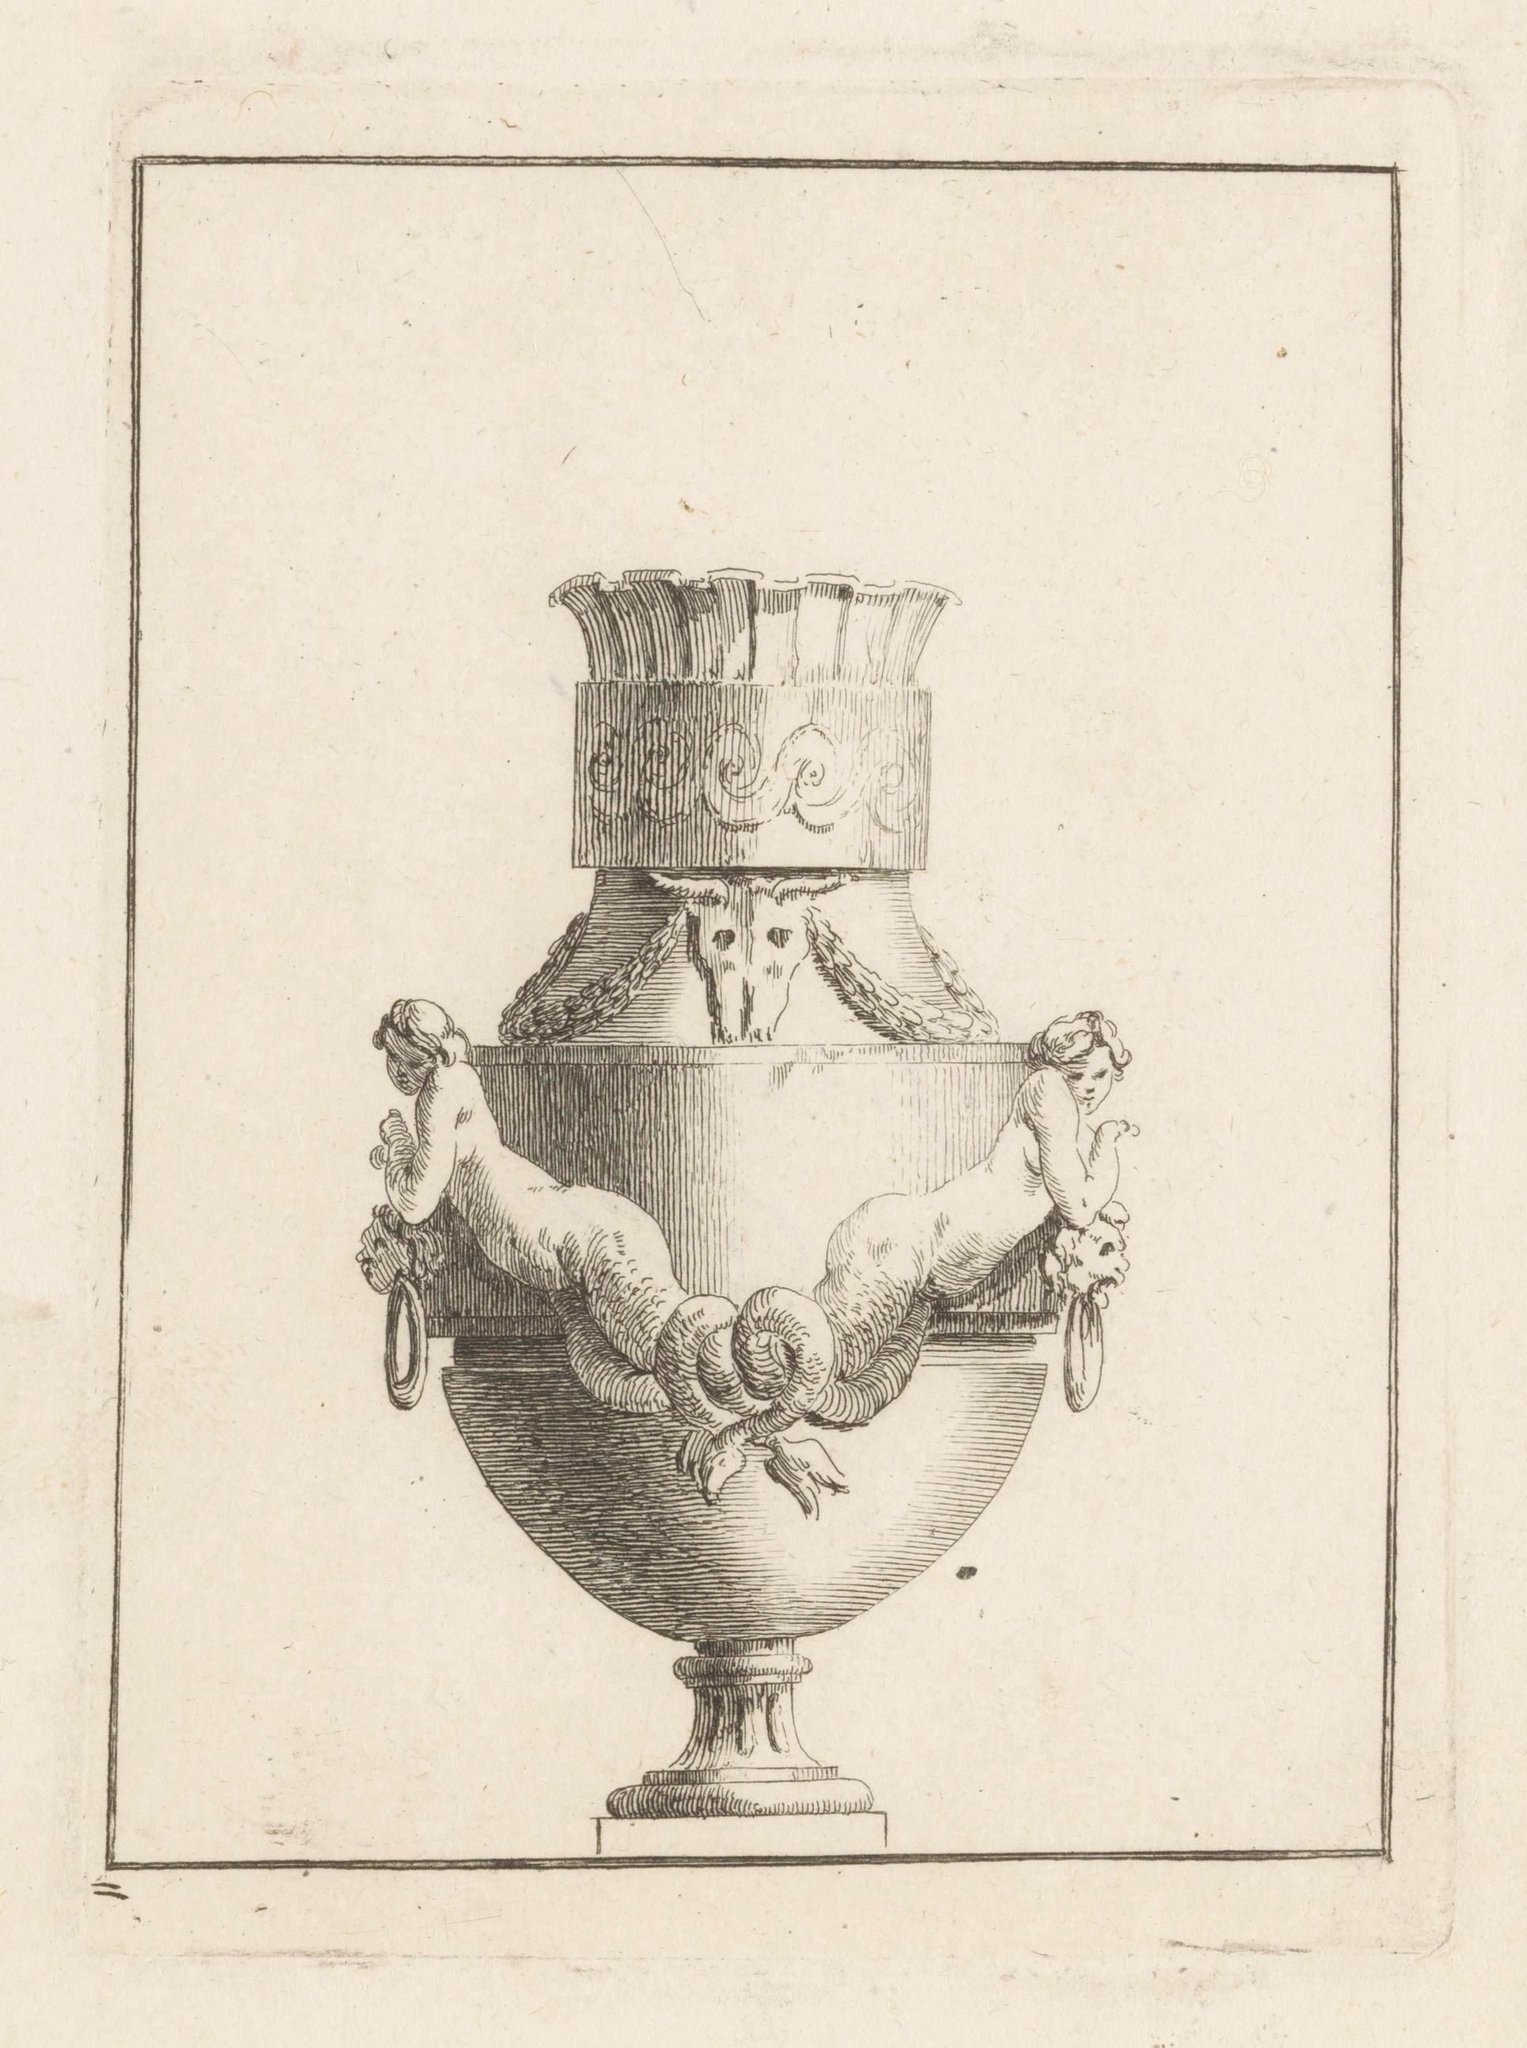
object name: ornament print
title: Vaas met meerminnen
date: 1755-1782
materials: paper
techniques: etching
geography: paris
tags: bucranium ~ ornament, merman - aa - mermaid, siren, vase ~ ornament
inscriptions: collector's mark: Lugt 2228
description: Deze prent is onderdeel van een serie van acht.